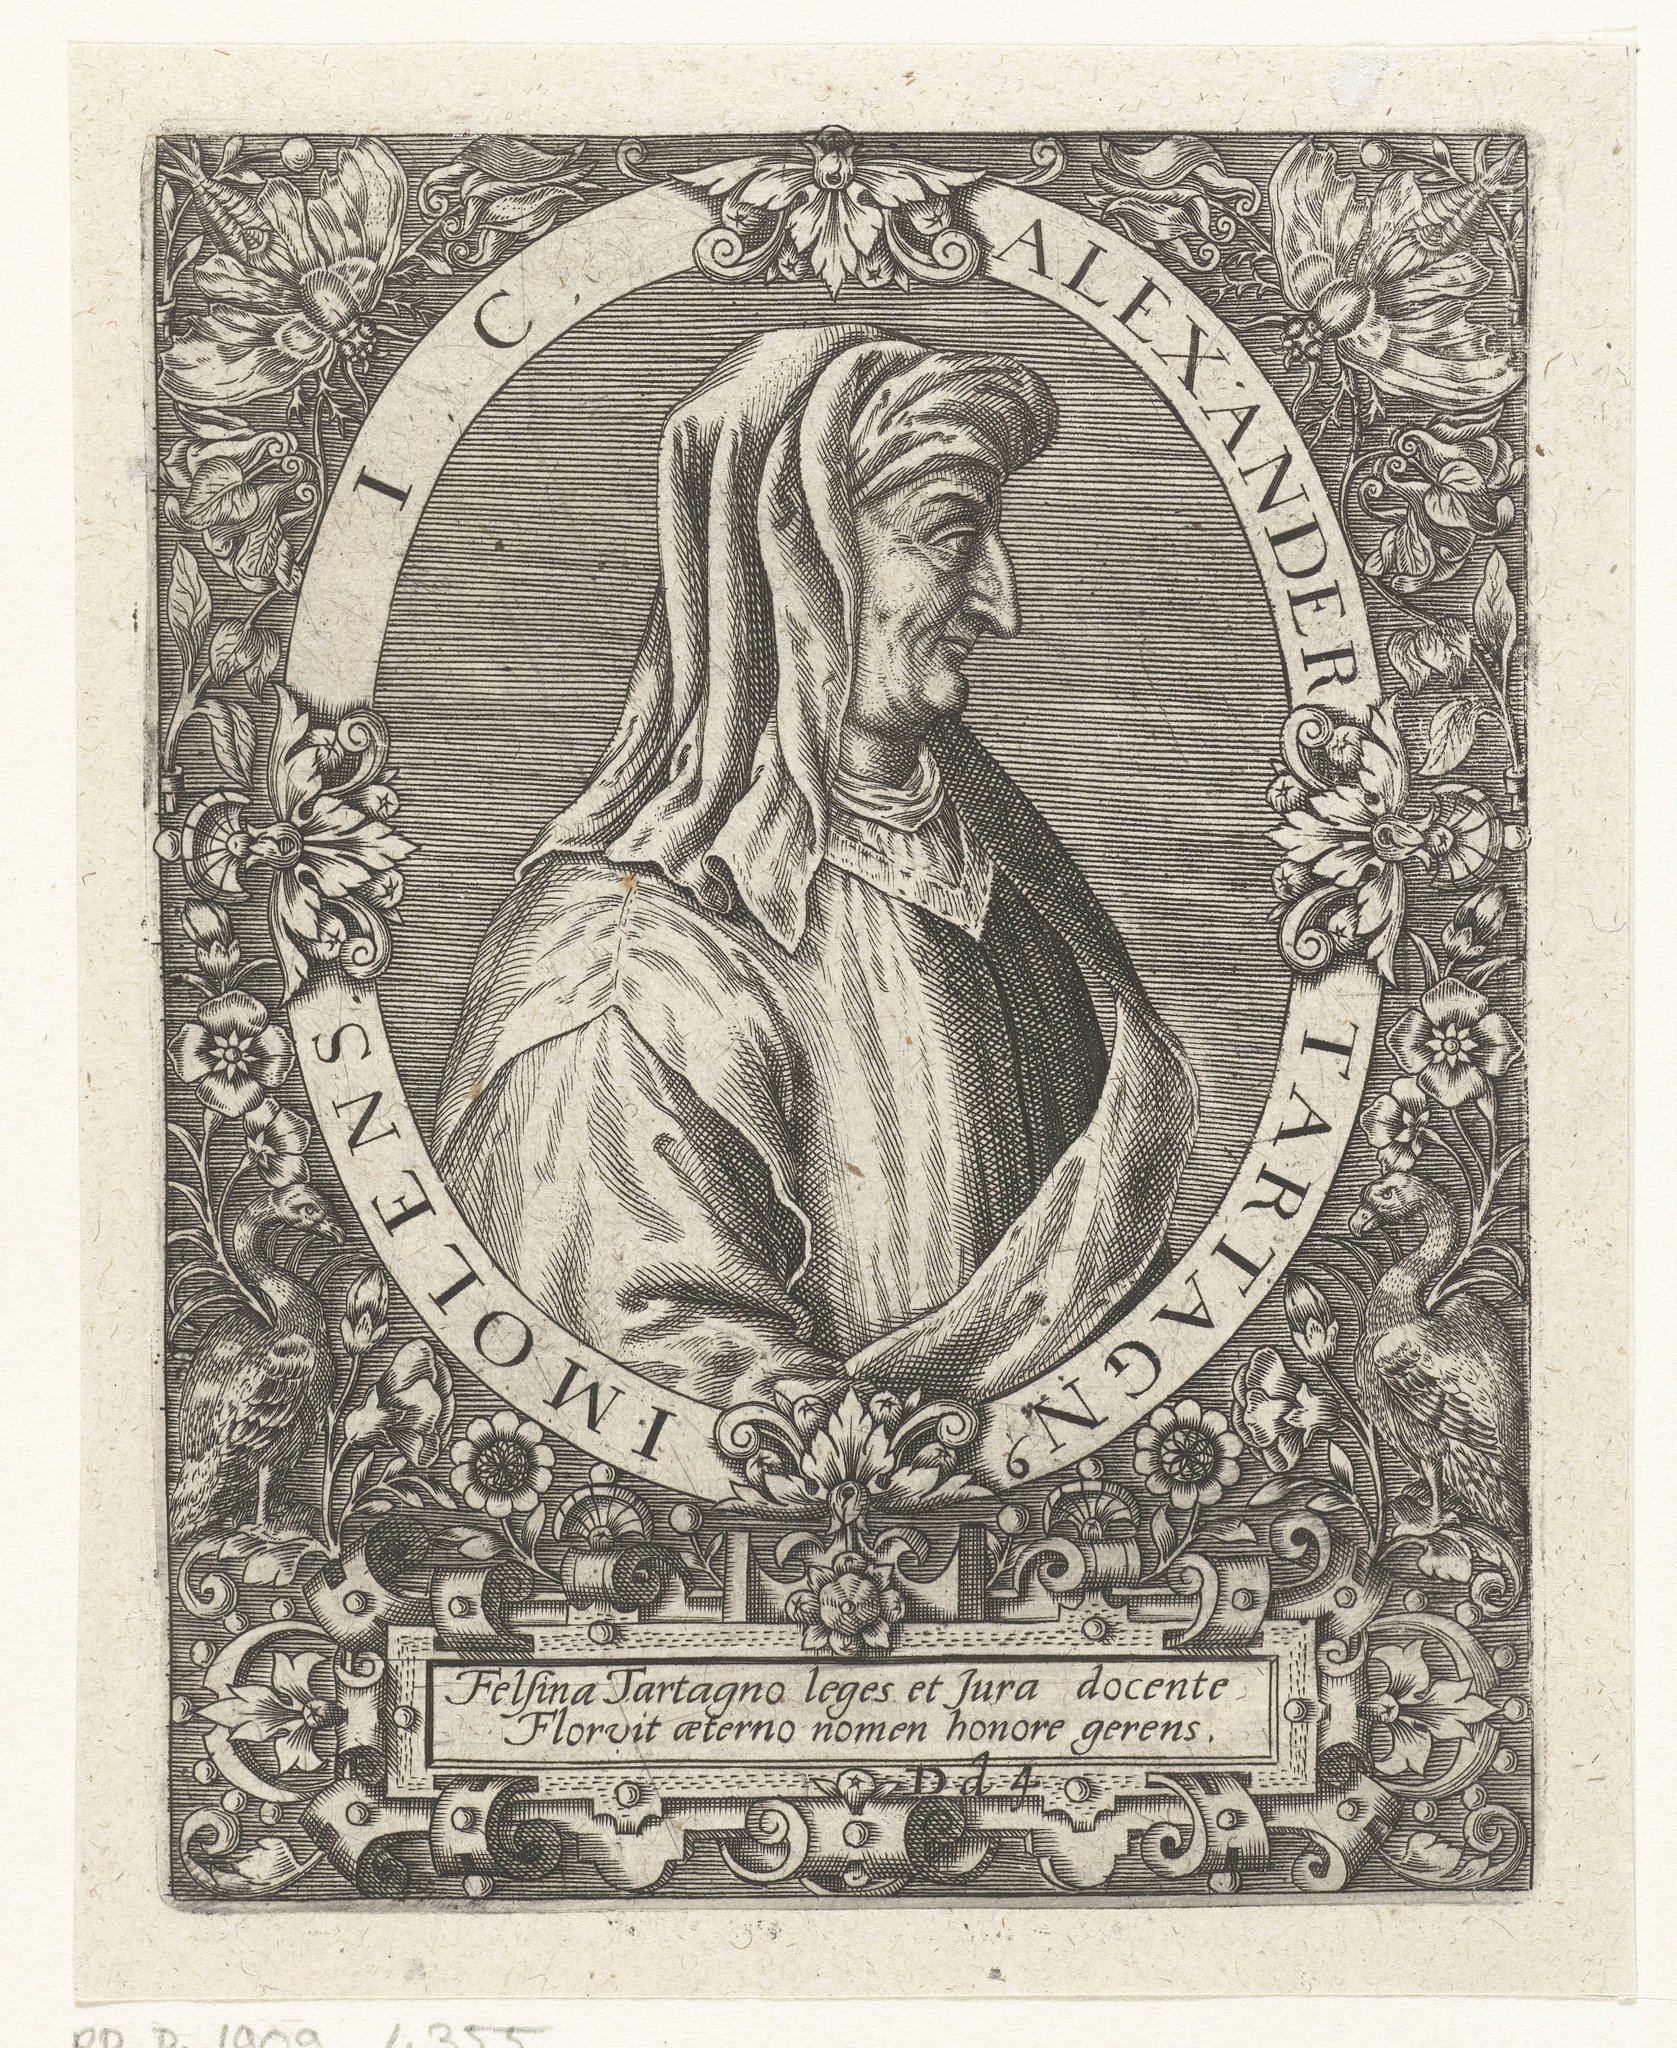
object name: print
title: Alexander Tartagnus Imolens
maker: jean jacques boissard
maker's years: 1528-1598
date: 1669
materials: paper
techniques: engraving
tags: jurist, alexander de tartagnis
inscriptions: collector's mark: Lugt 2228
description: Gemaakt voor: J.J. Boissard, Icones virorum illustrium doctrina &c eruditione praestanti um contines. Frankfurt am Main: de Bry, 1597-1599. Opnieuw gebruikt in: J.J.Boissard, Bibliotheca chalcographica, hoc est Virtute et eruditione clarorum Virorum Imagines. Heidelberg: Clemens Ammon, 1669. Dl. 1-5 (te herkennen aan de toegevoegde signatuur in de rechter onderhoek: 2D4).